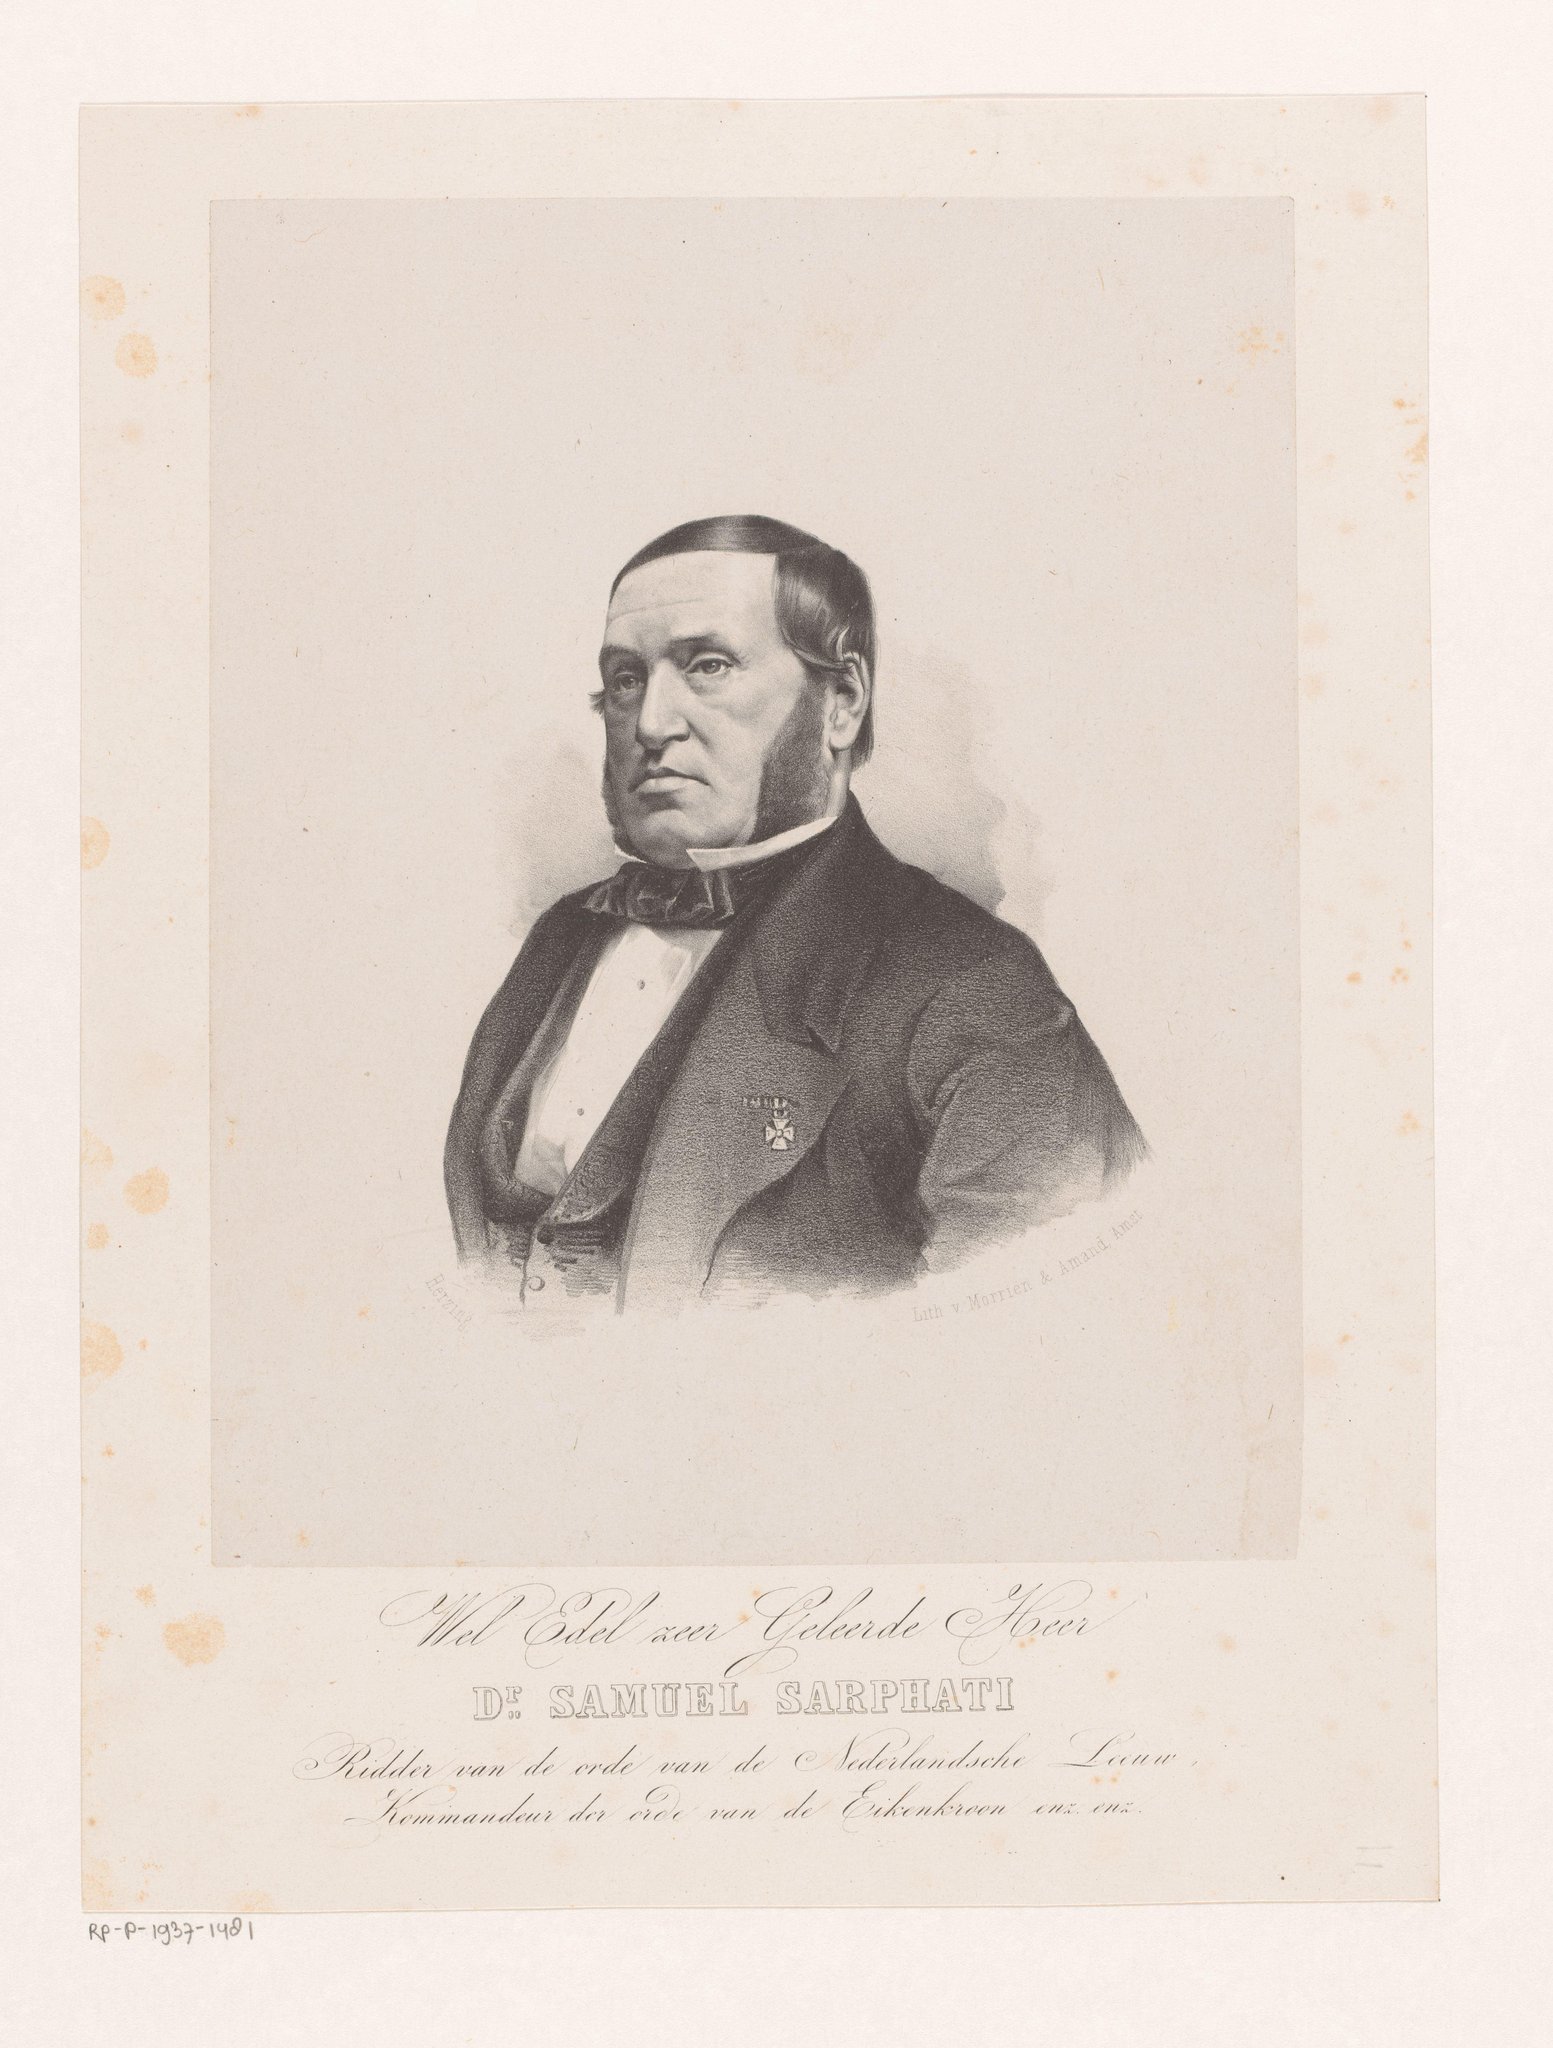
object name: print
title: Portret van Samuel Sarphati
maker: andreas sebastian herzing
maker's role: print maker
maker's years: 1845-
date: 1865-1866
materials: paper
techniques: lithograph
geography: amsterdam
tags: amsterdam, samuel sarphati, knighthood order, historical persons (+ (full) bust portrait)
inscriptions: collector's mark: Lugt 2760, collector's mark: Lugt 2228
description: Onder het portret de naam en onderscheidingen van de geportretteerde.